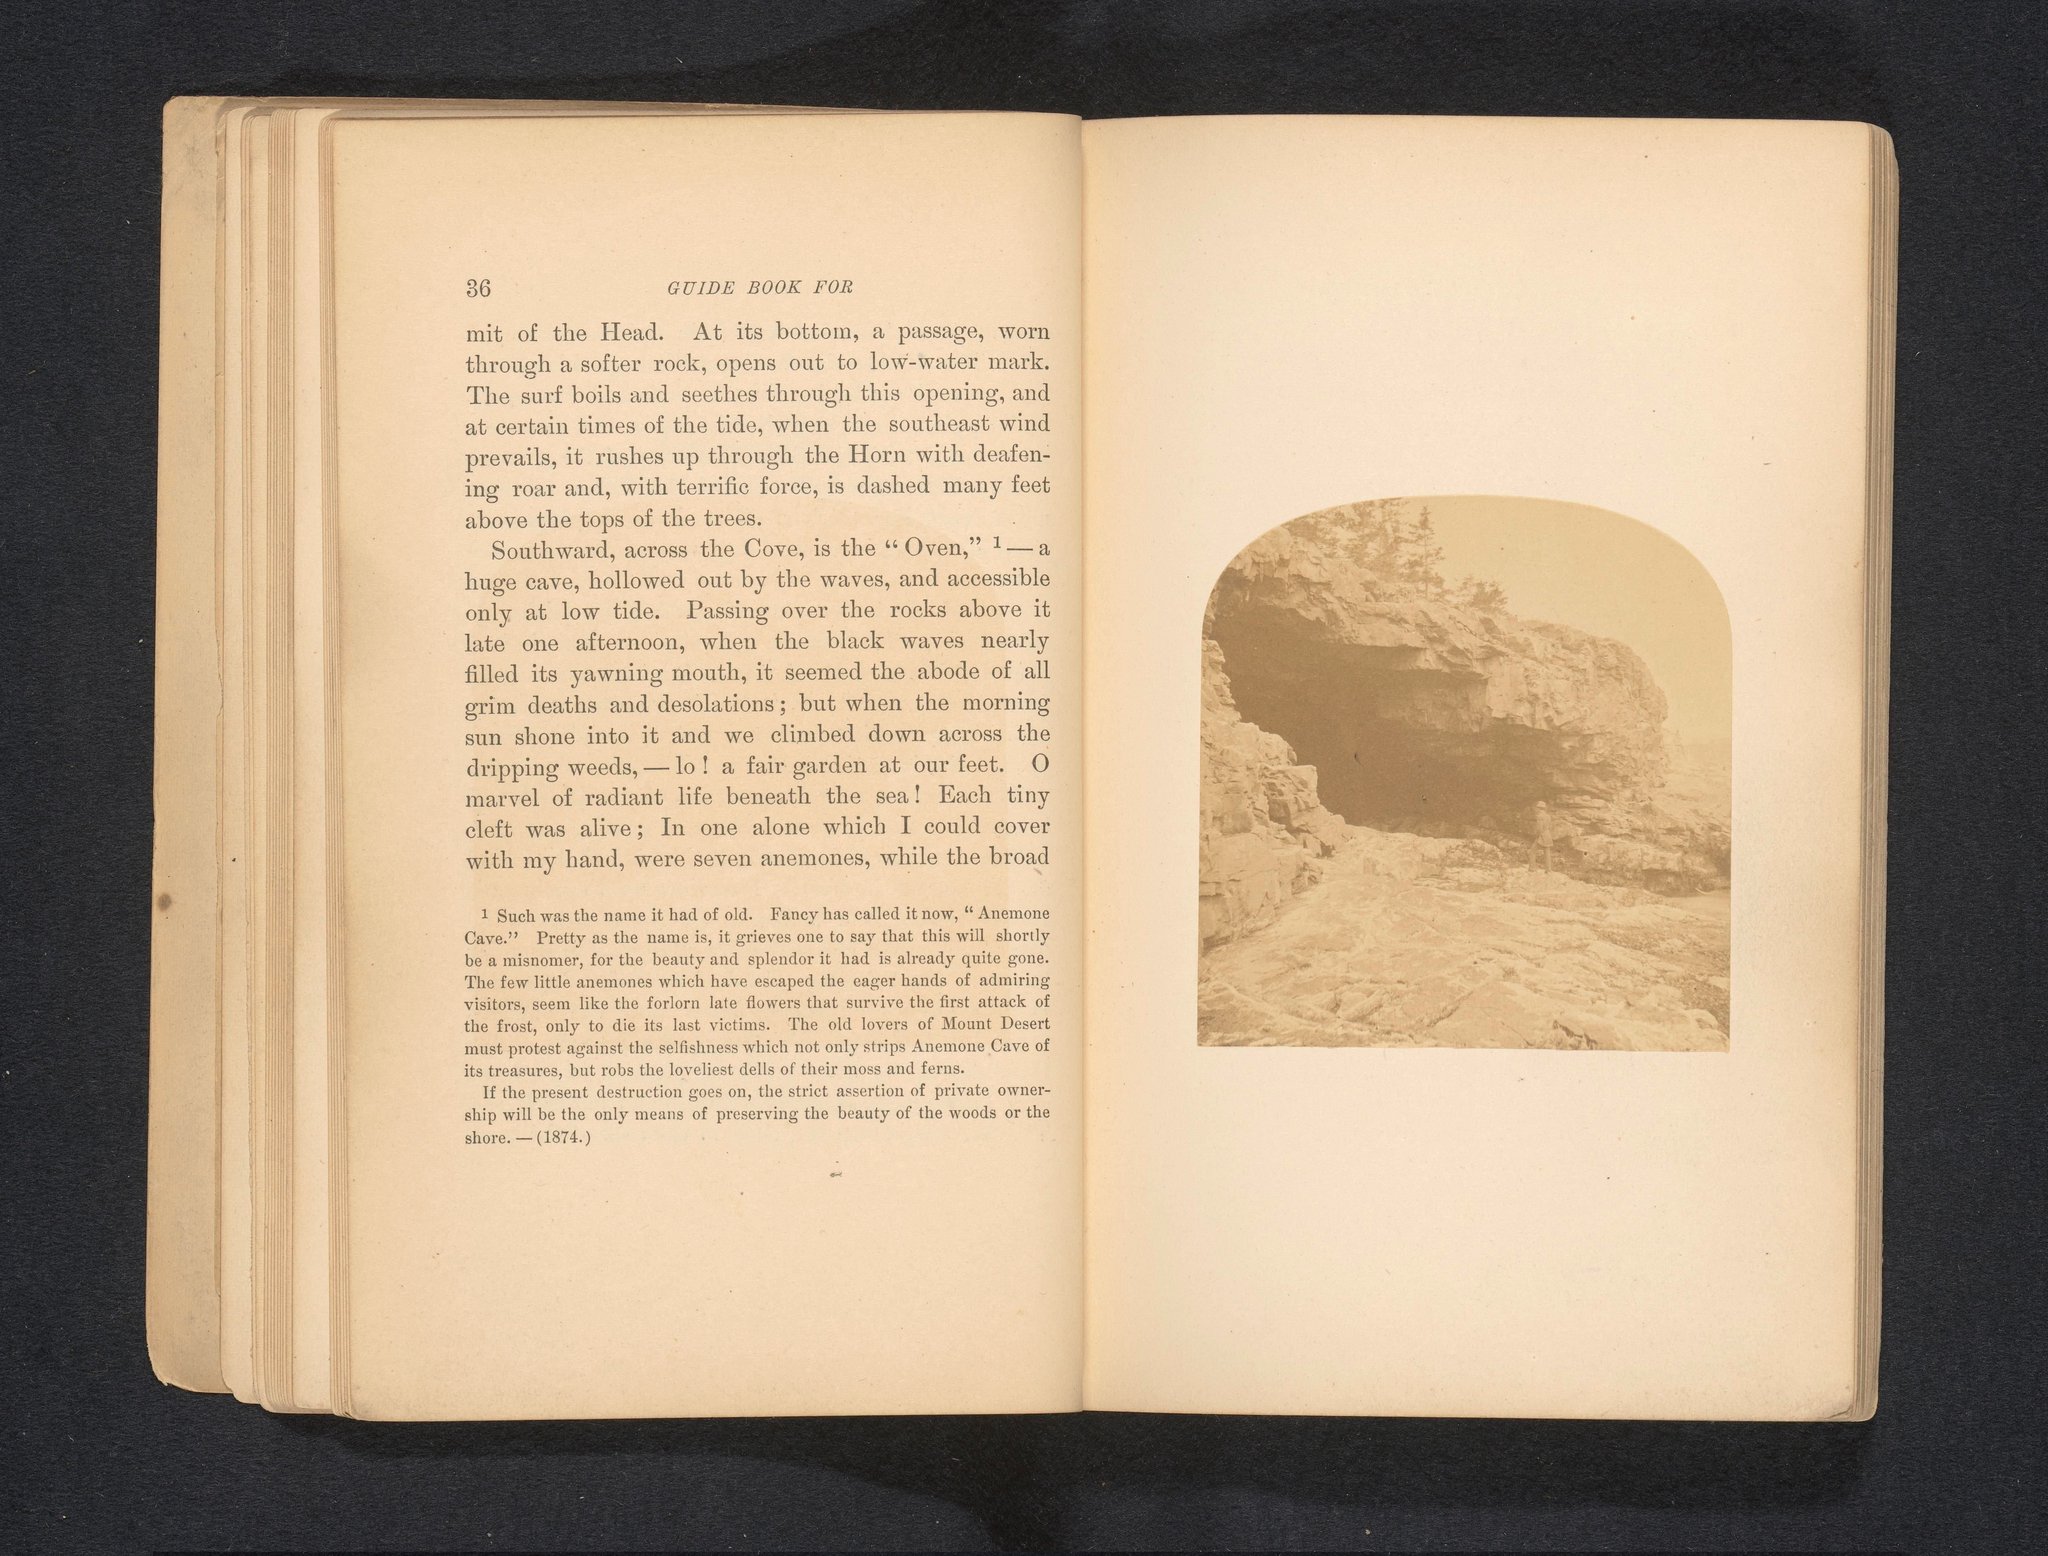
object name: page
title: Gezicht op een grot nabij Schooner Head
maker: Anonymous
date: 1877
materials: photographic support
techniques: albumen print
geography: mount desert island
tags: landscapes, cave, grotto